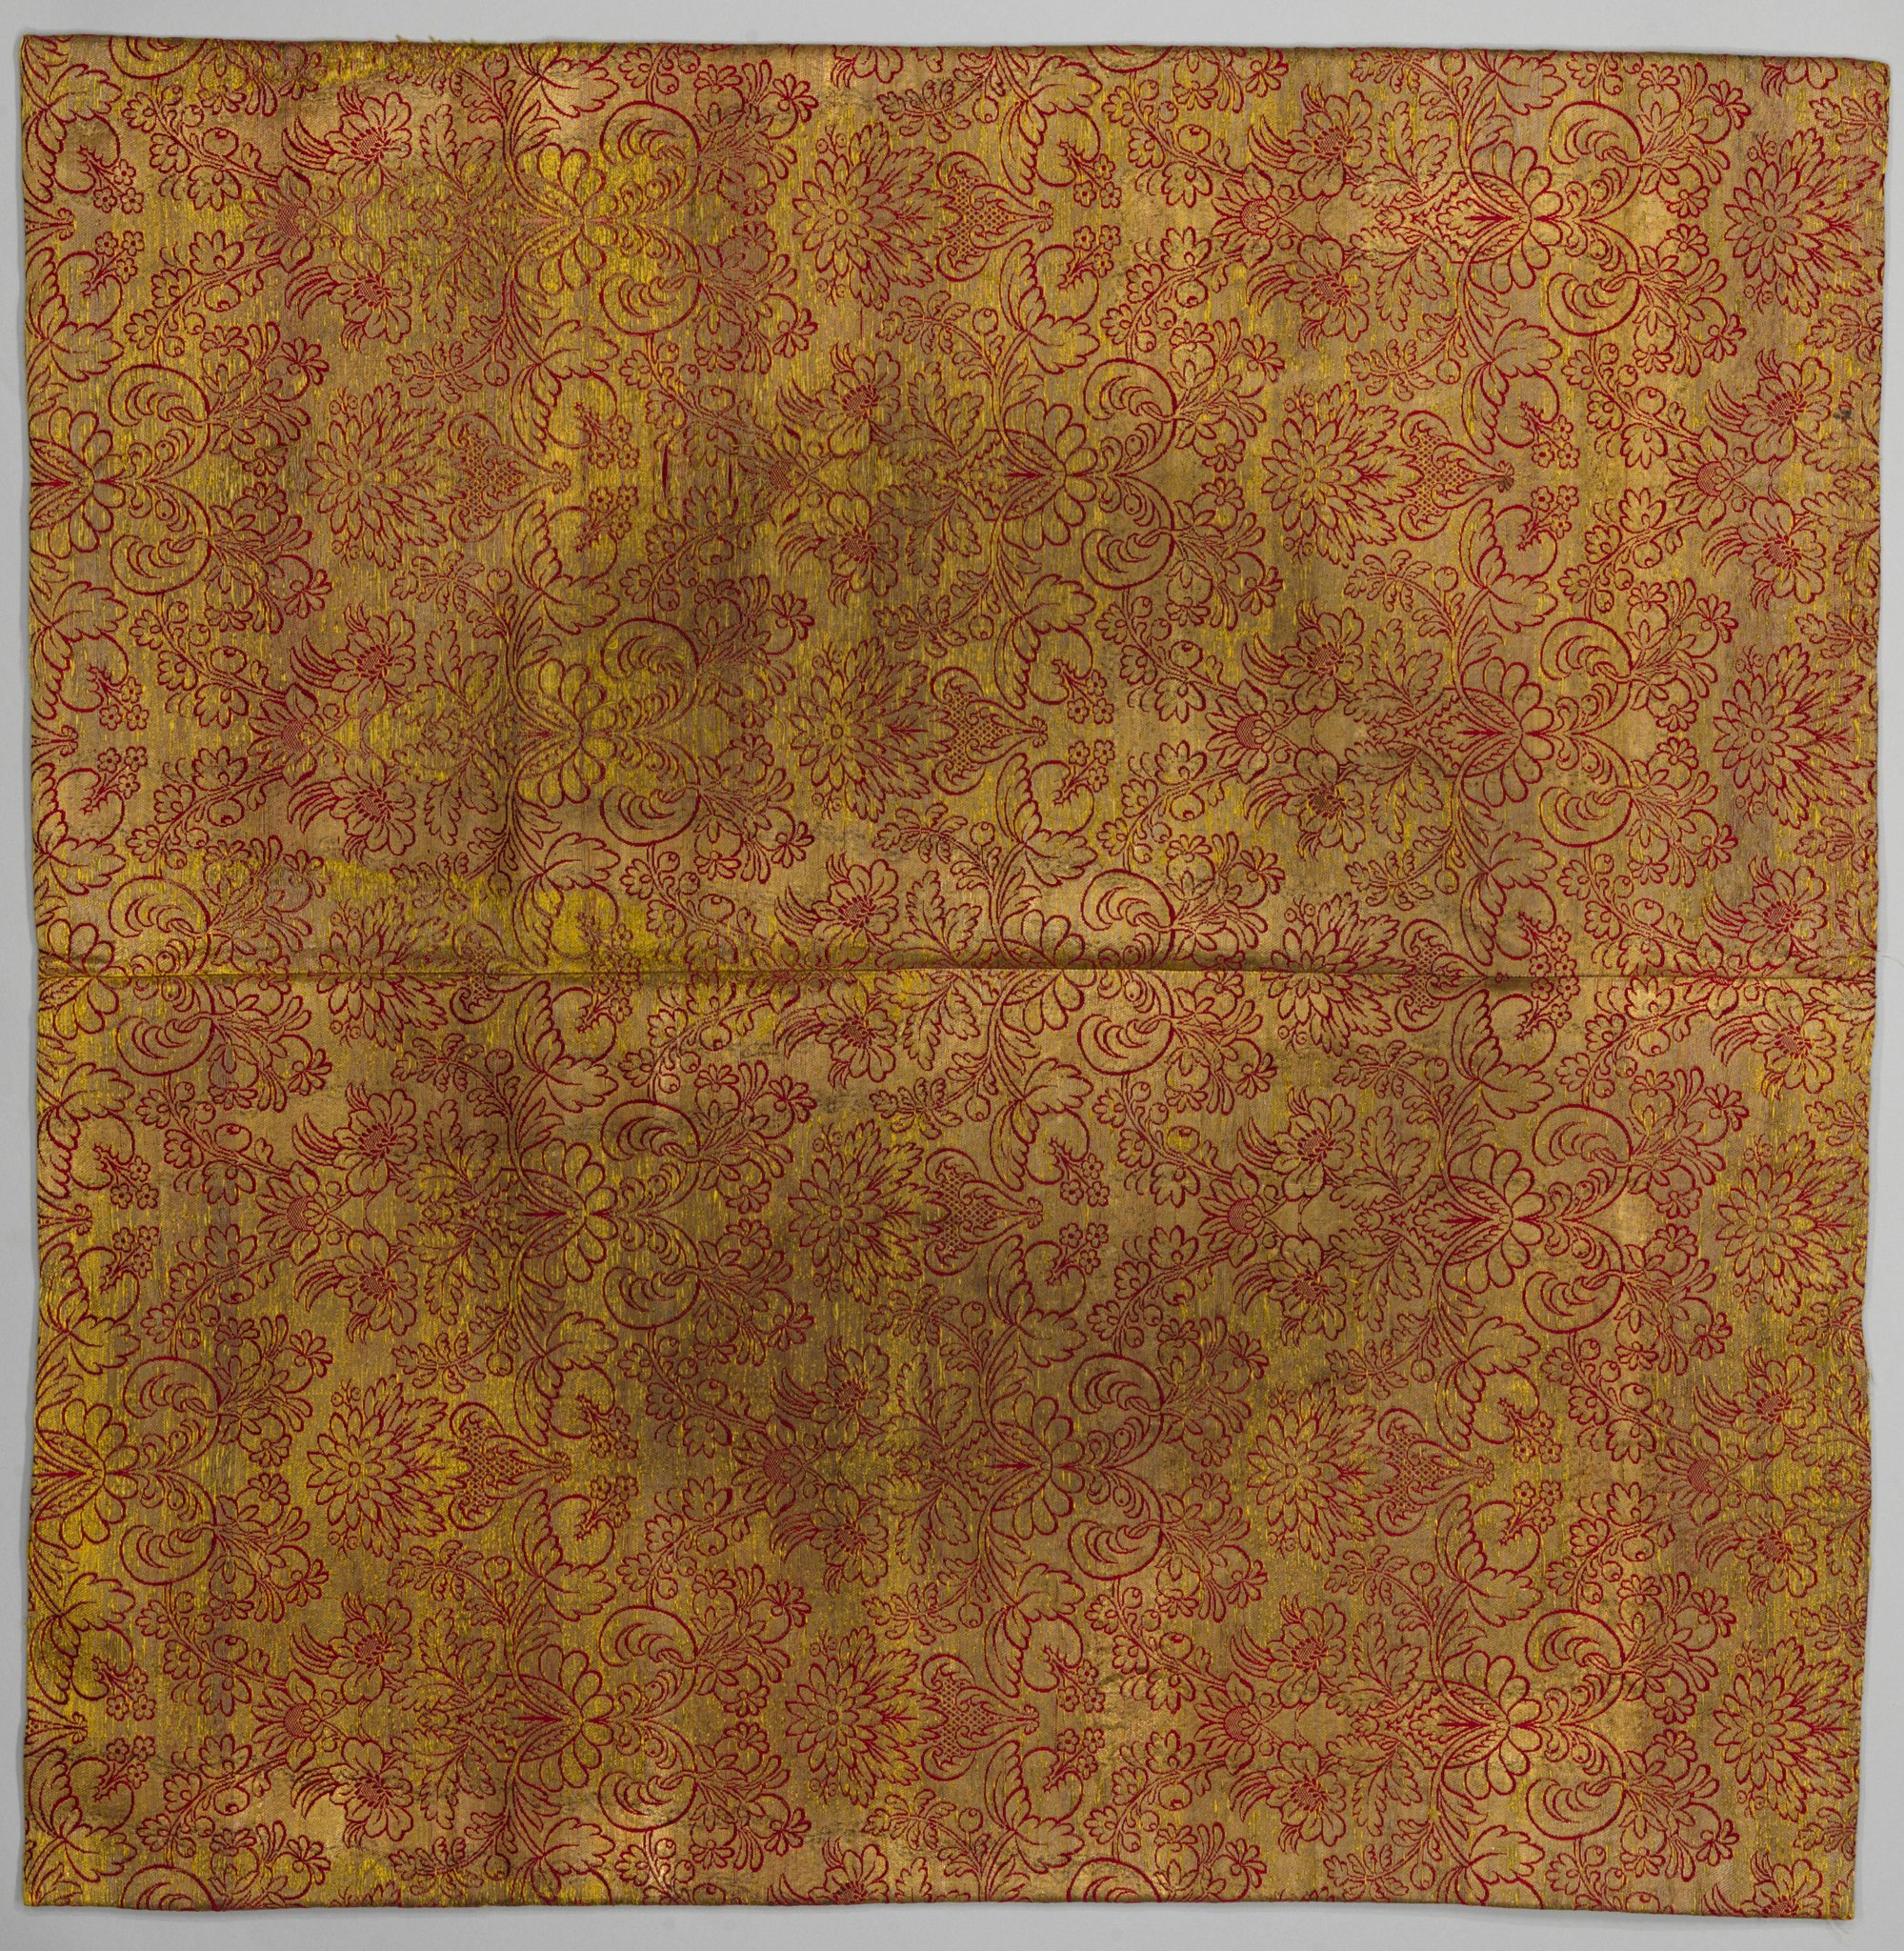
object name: kleed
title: Kleed van gebrocheerde en met zilverdraad gearceerde zijdedamast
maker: Anonymous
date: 1715-1725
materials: silk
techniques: brocade, damask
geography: france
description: Kleed van gebrocheerde en met zilverdraad gearceerde zijdedamast.Dessin: ruitpatroon opgebouwd uit bloemranken met op de zijden bladarrangementen in zilver, roze, geel en rood op een groen fond met dessin van bloemen en bladeren. Gevoerd met gele zijde. Opgespeld papier waarop de letters AR. Aan achterzijde gestempeld: 16408. Het weefsel is vermaakt tot kleed, samengesteld uit twee herstelde banen. Toestand: kleur goed: herstellingen.